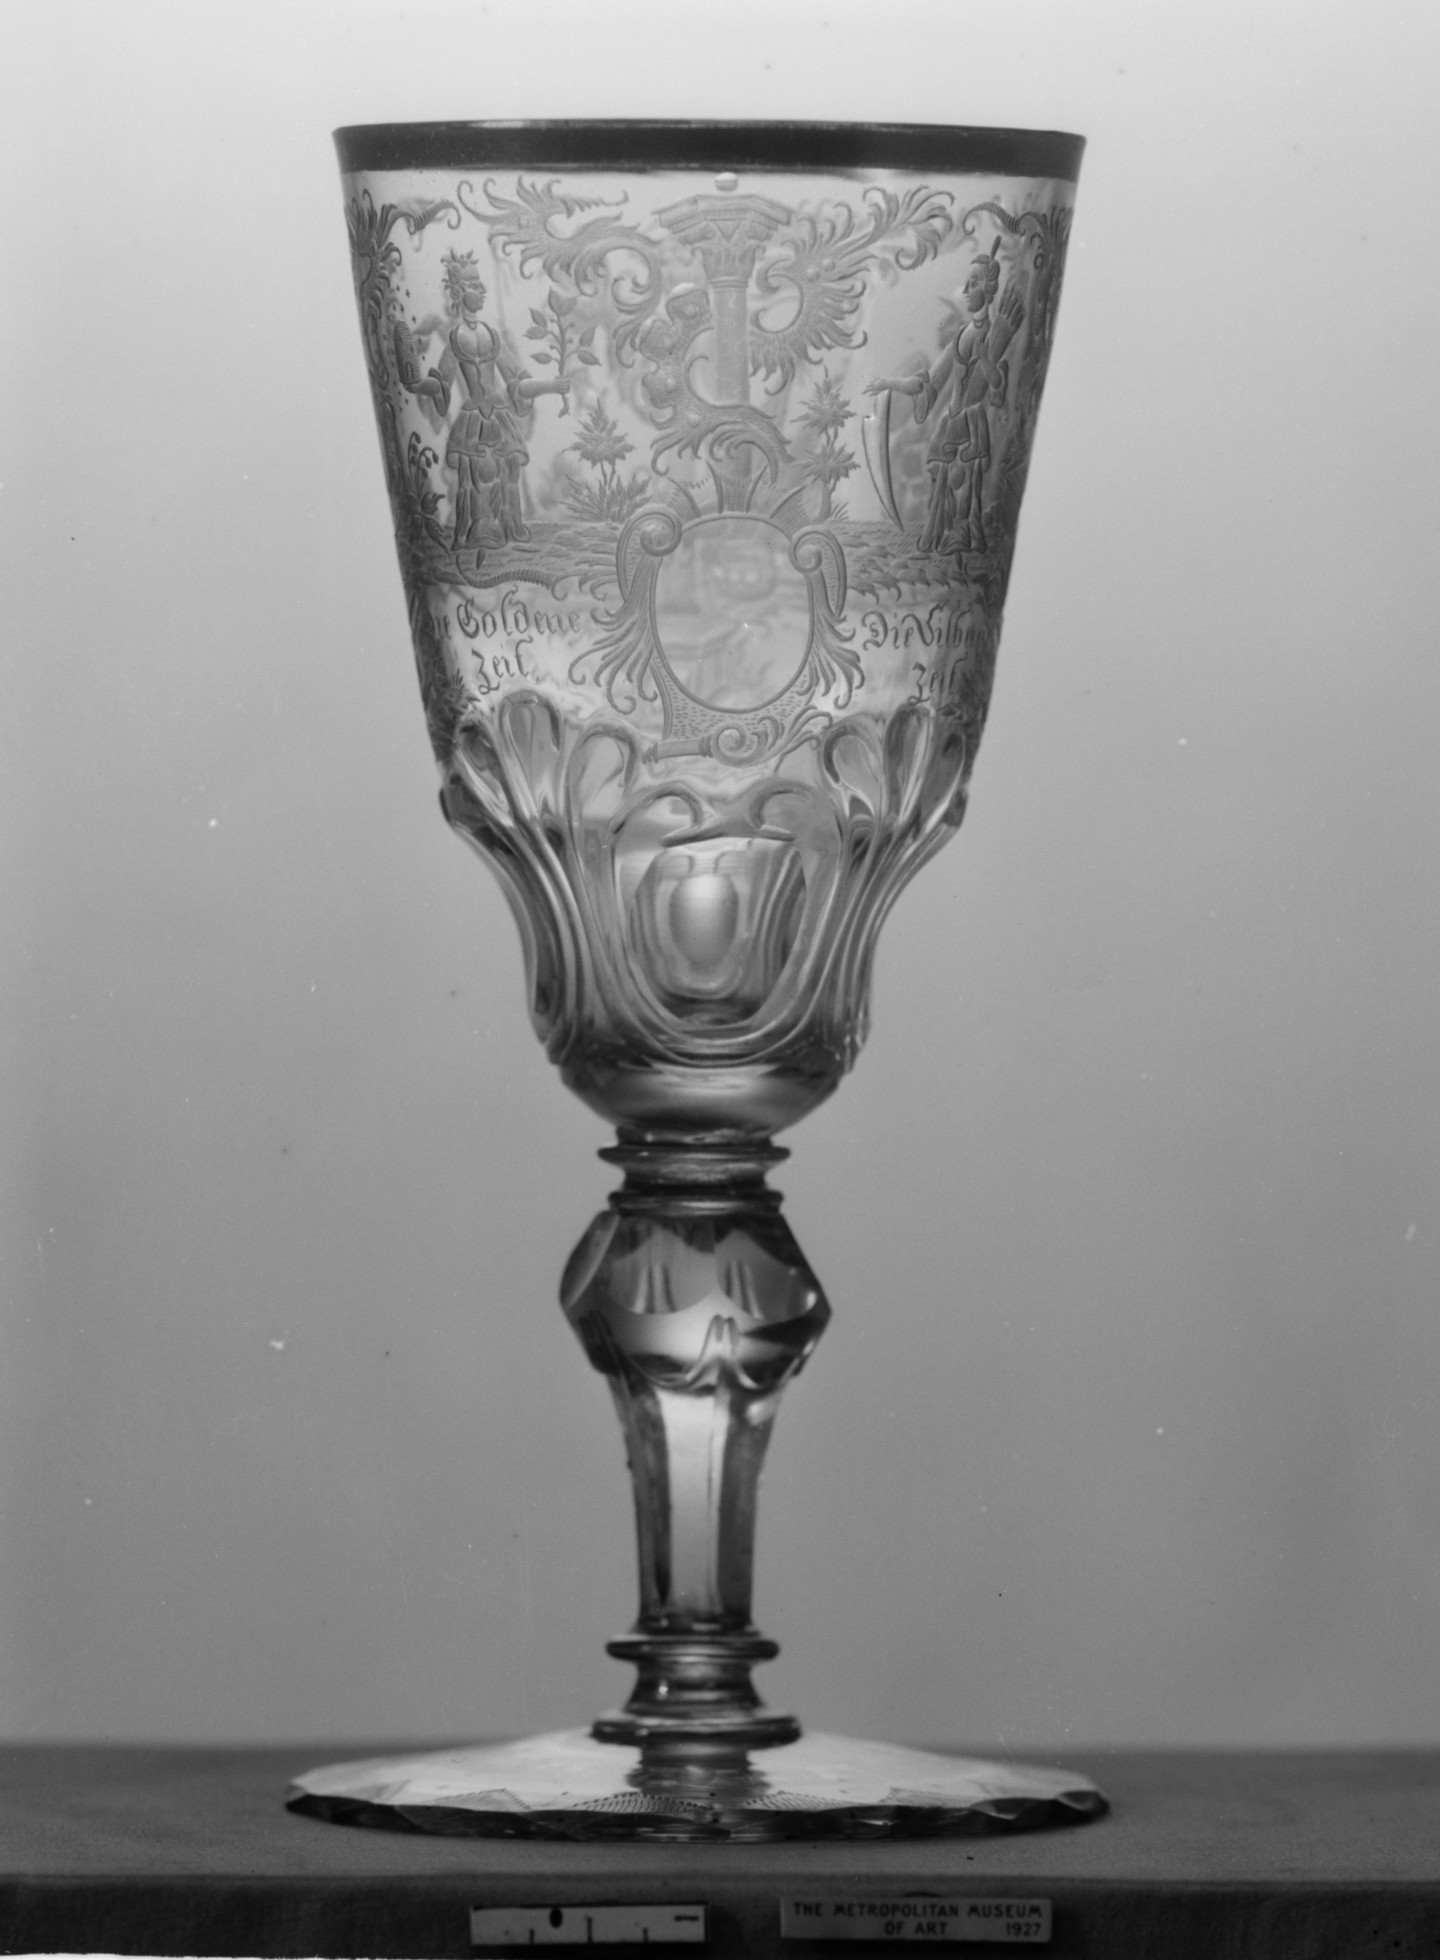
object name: wineglass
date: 1760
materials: glass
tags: coat of arms